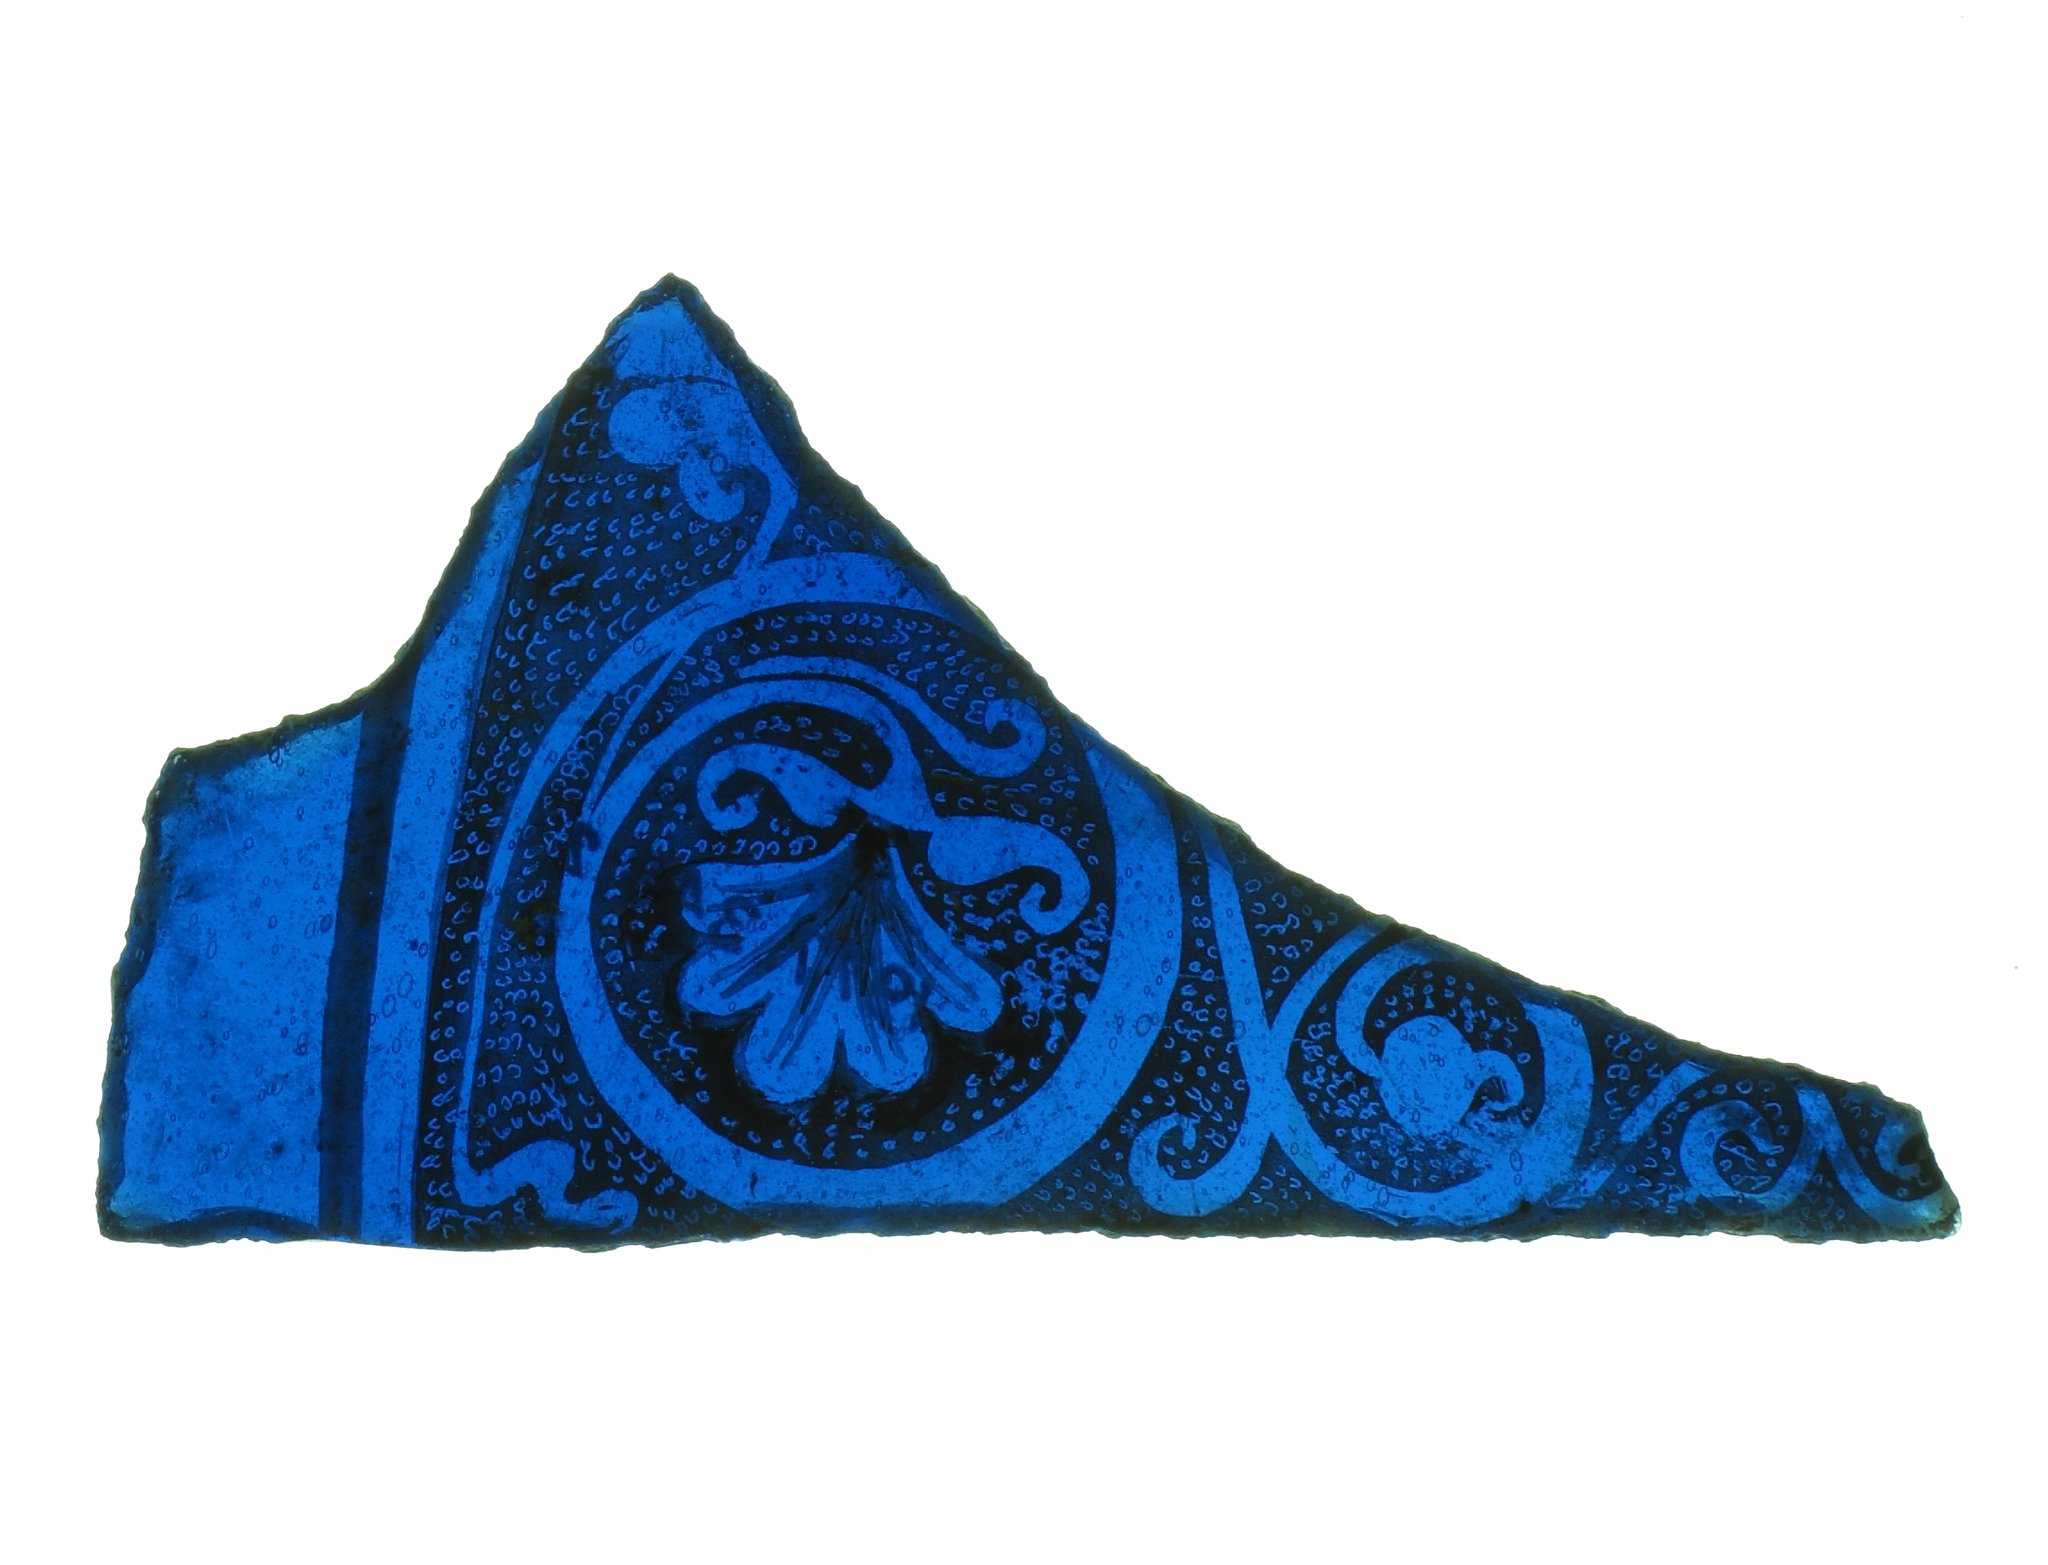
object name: fragment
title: Glass Fragment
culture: french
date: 1101-1400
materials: glass, metal, paint